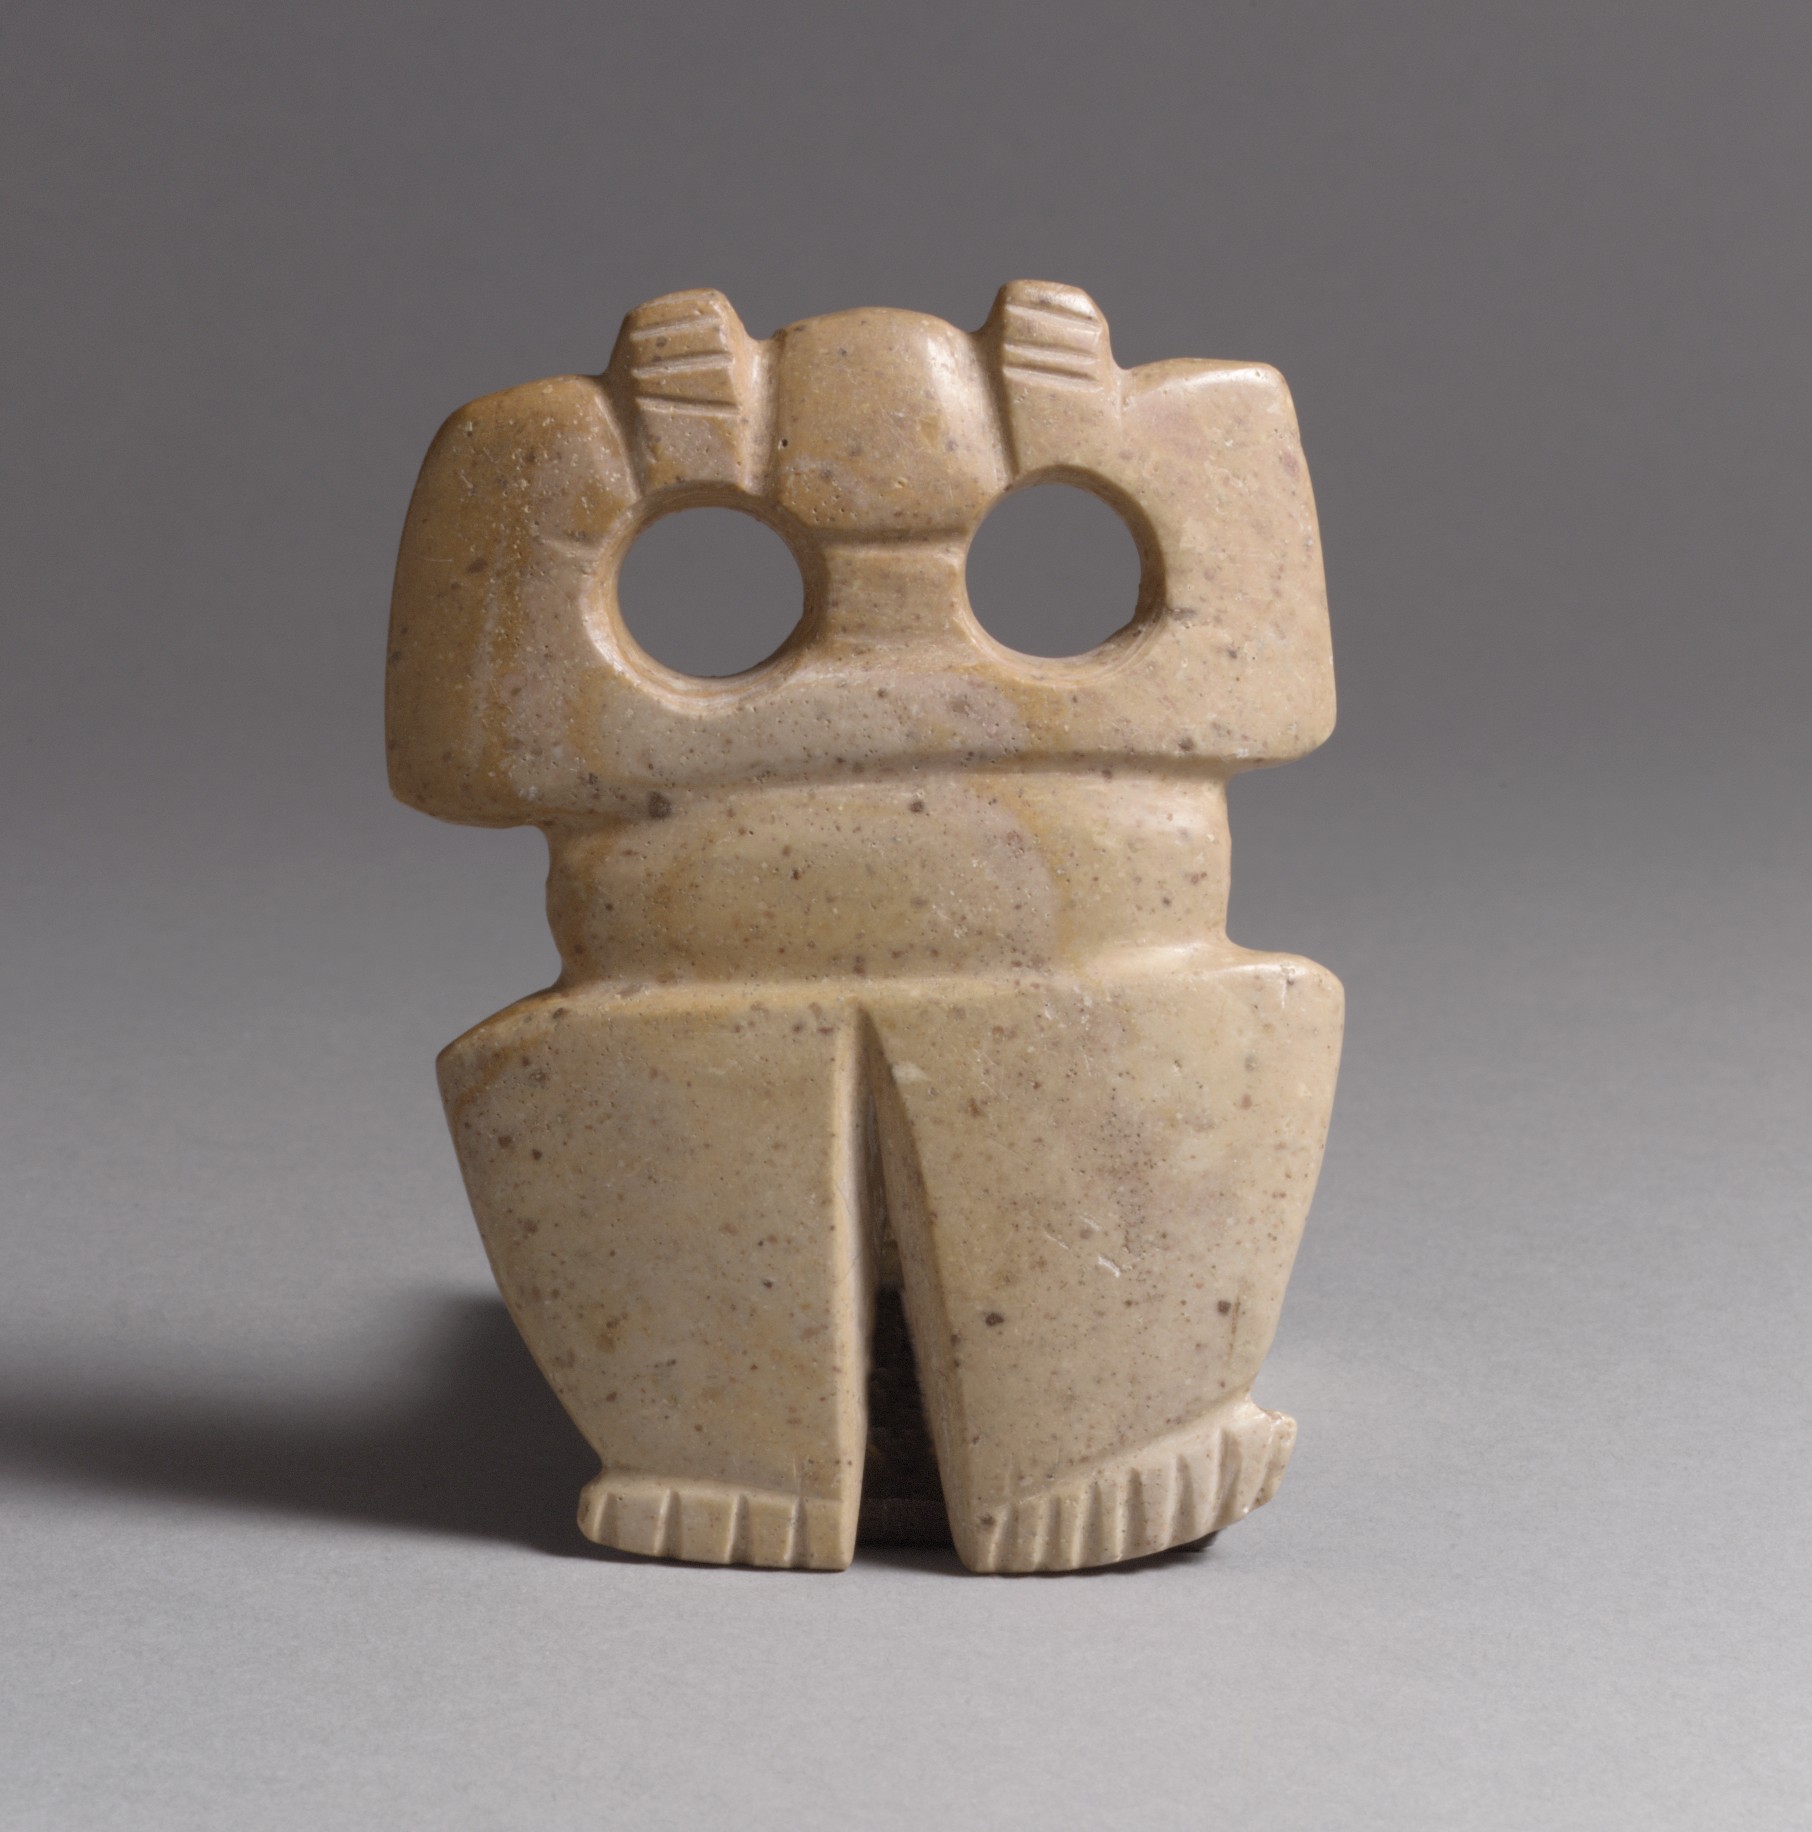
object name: pendant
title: Figure Pendant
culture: atlantic watershed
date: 301-800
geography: costa rica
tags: human figures